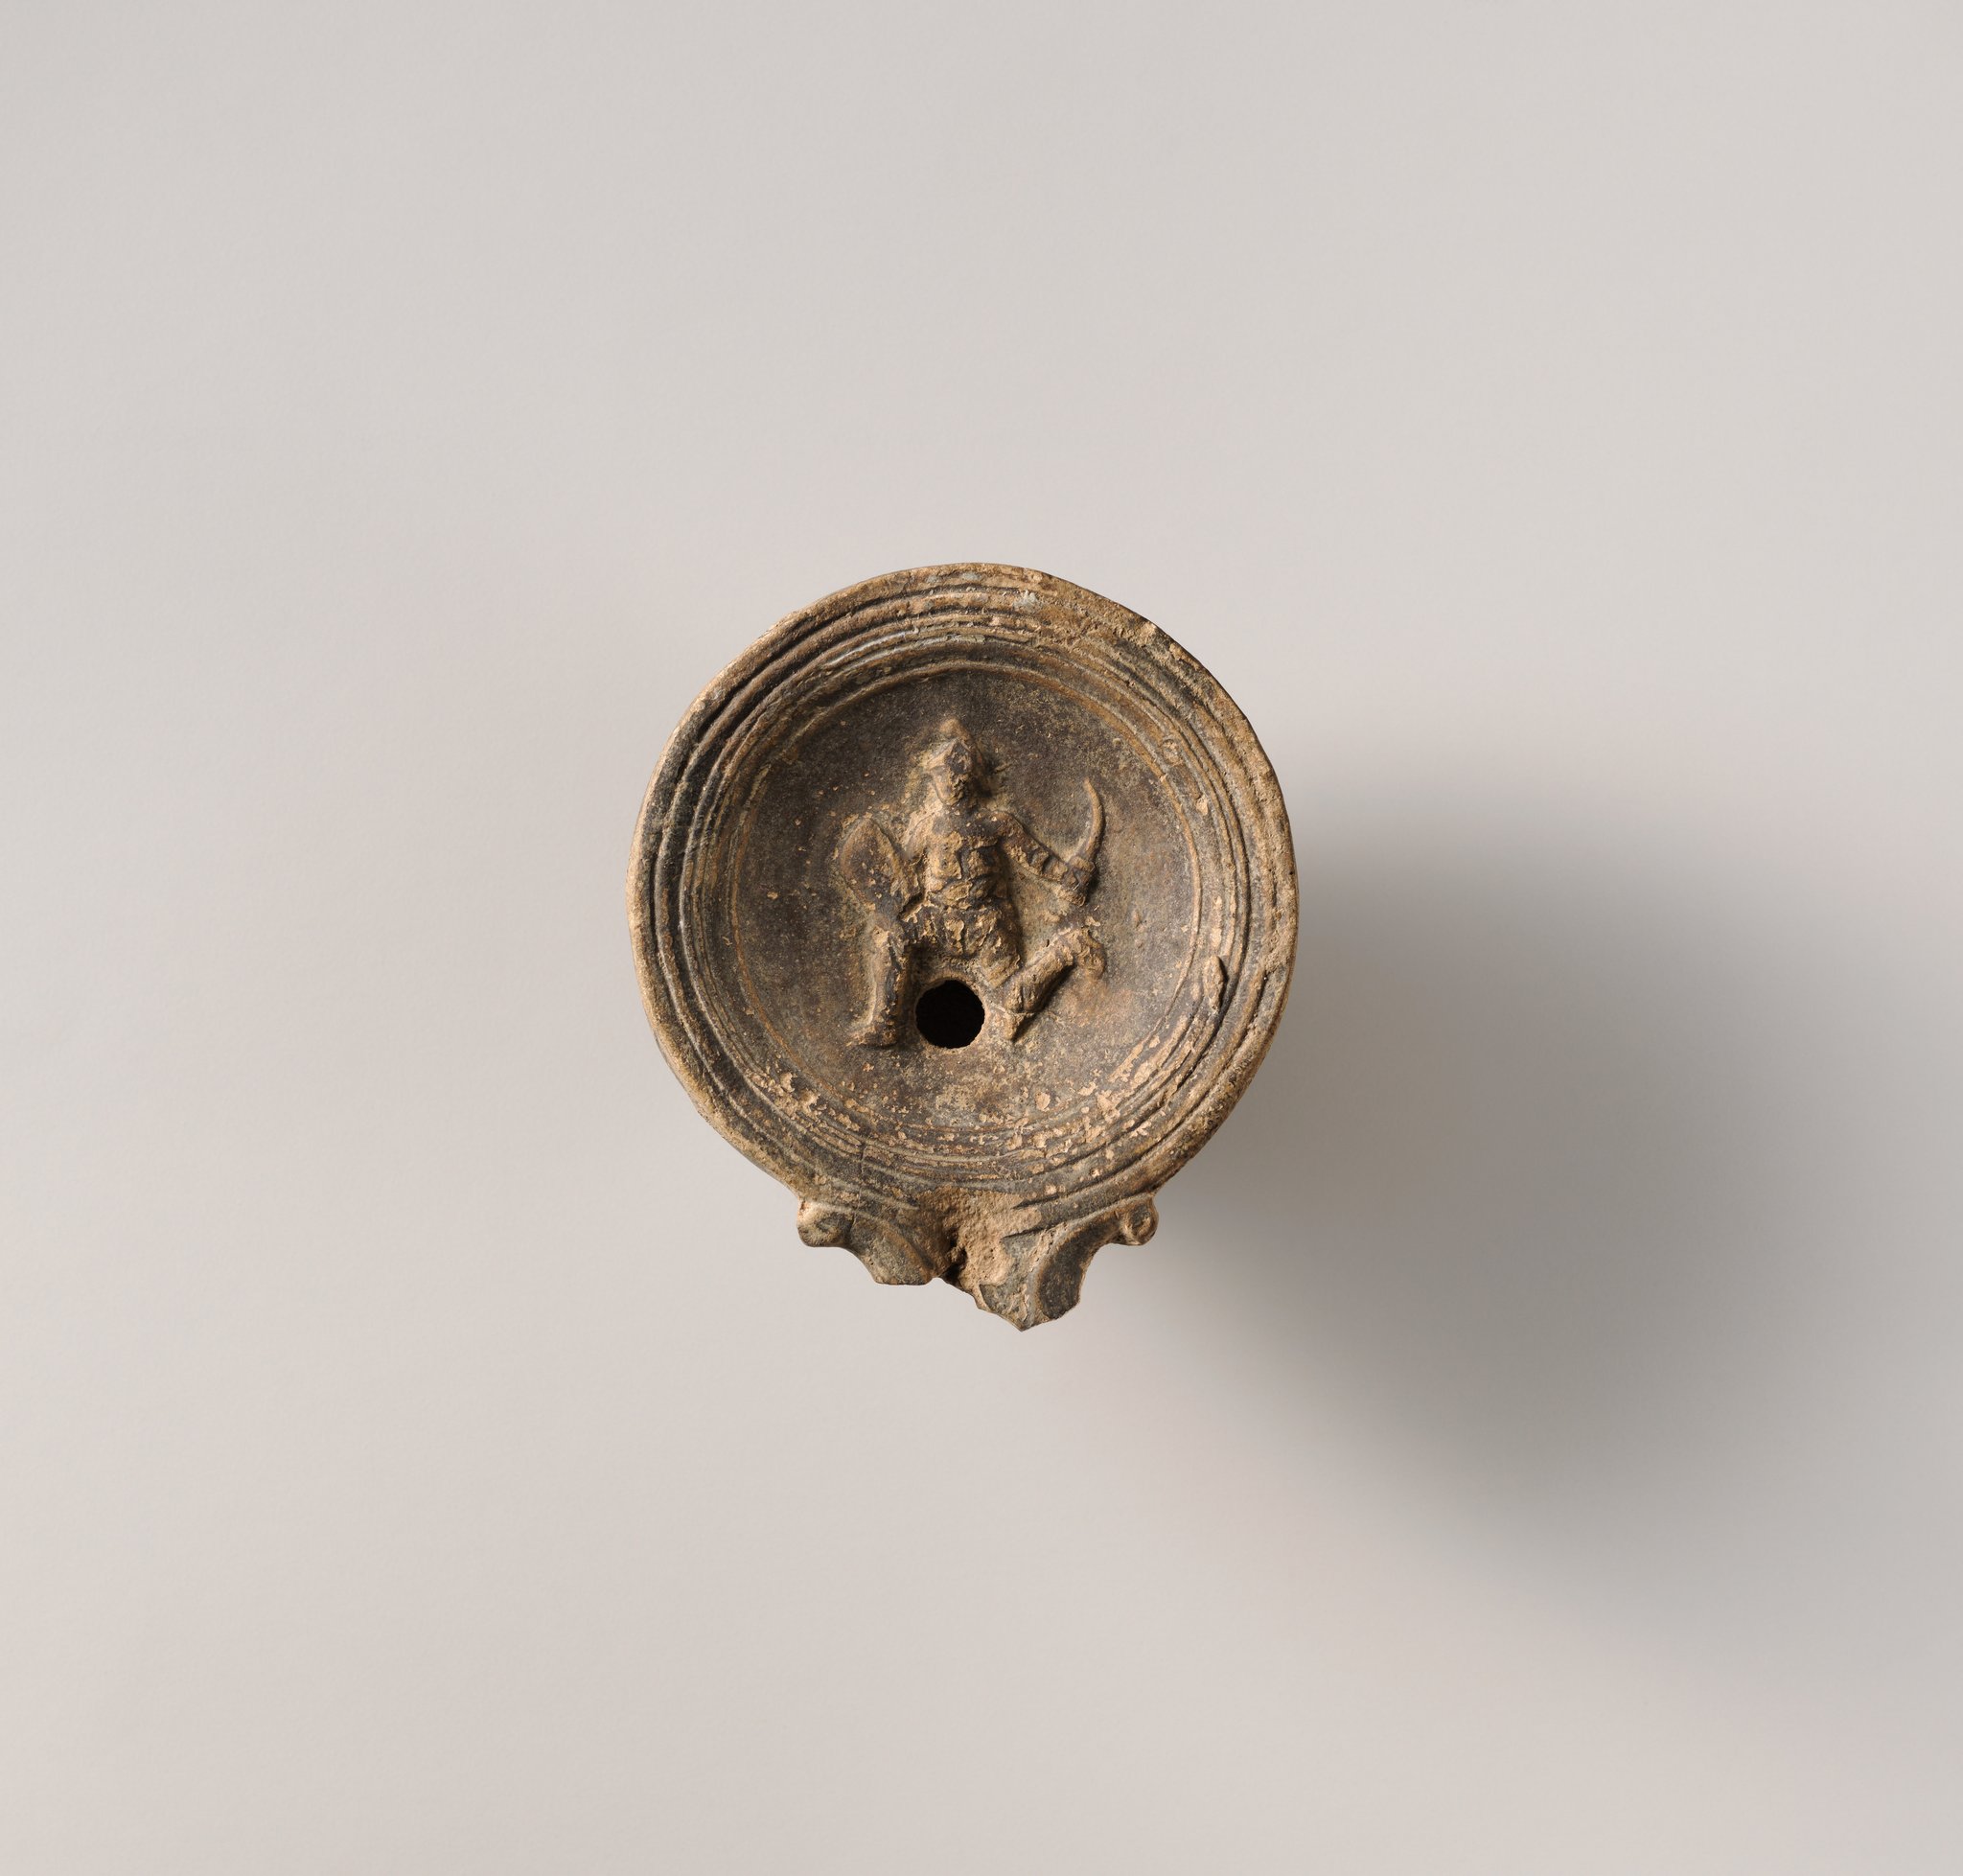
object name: lamp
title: Terracotta oil lamp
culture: roman, cypriot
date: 1-100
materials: terracotta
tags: gladiators